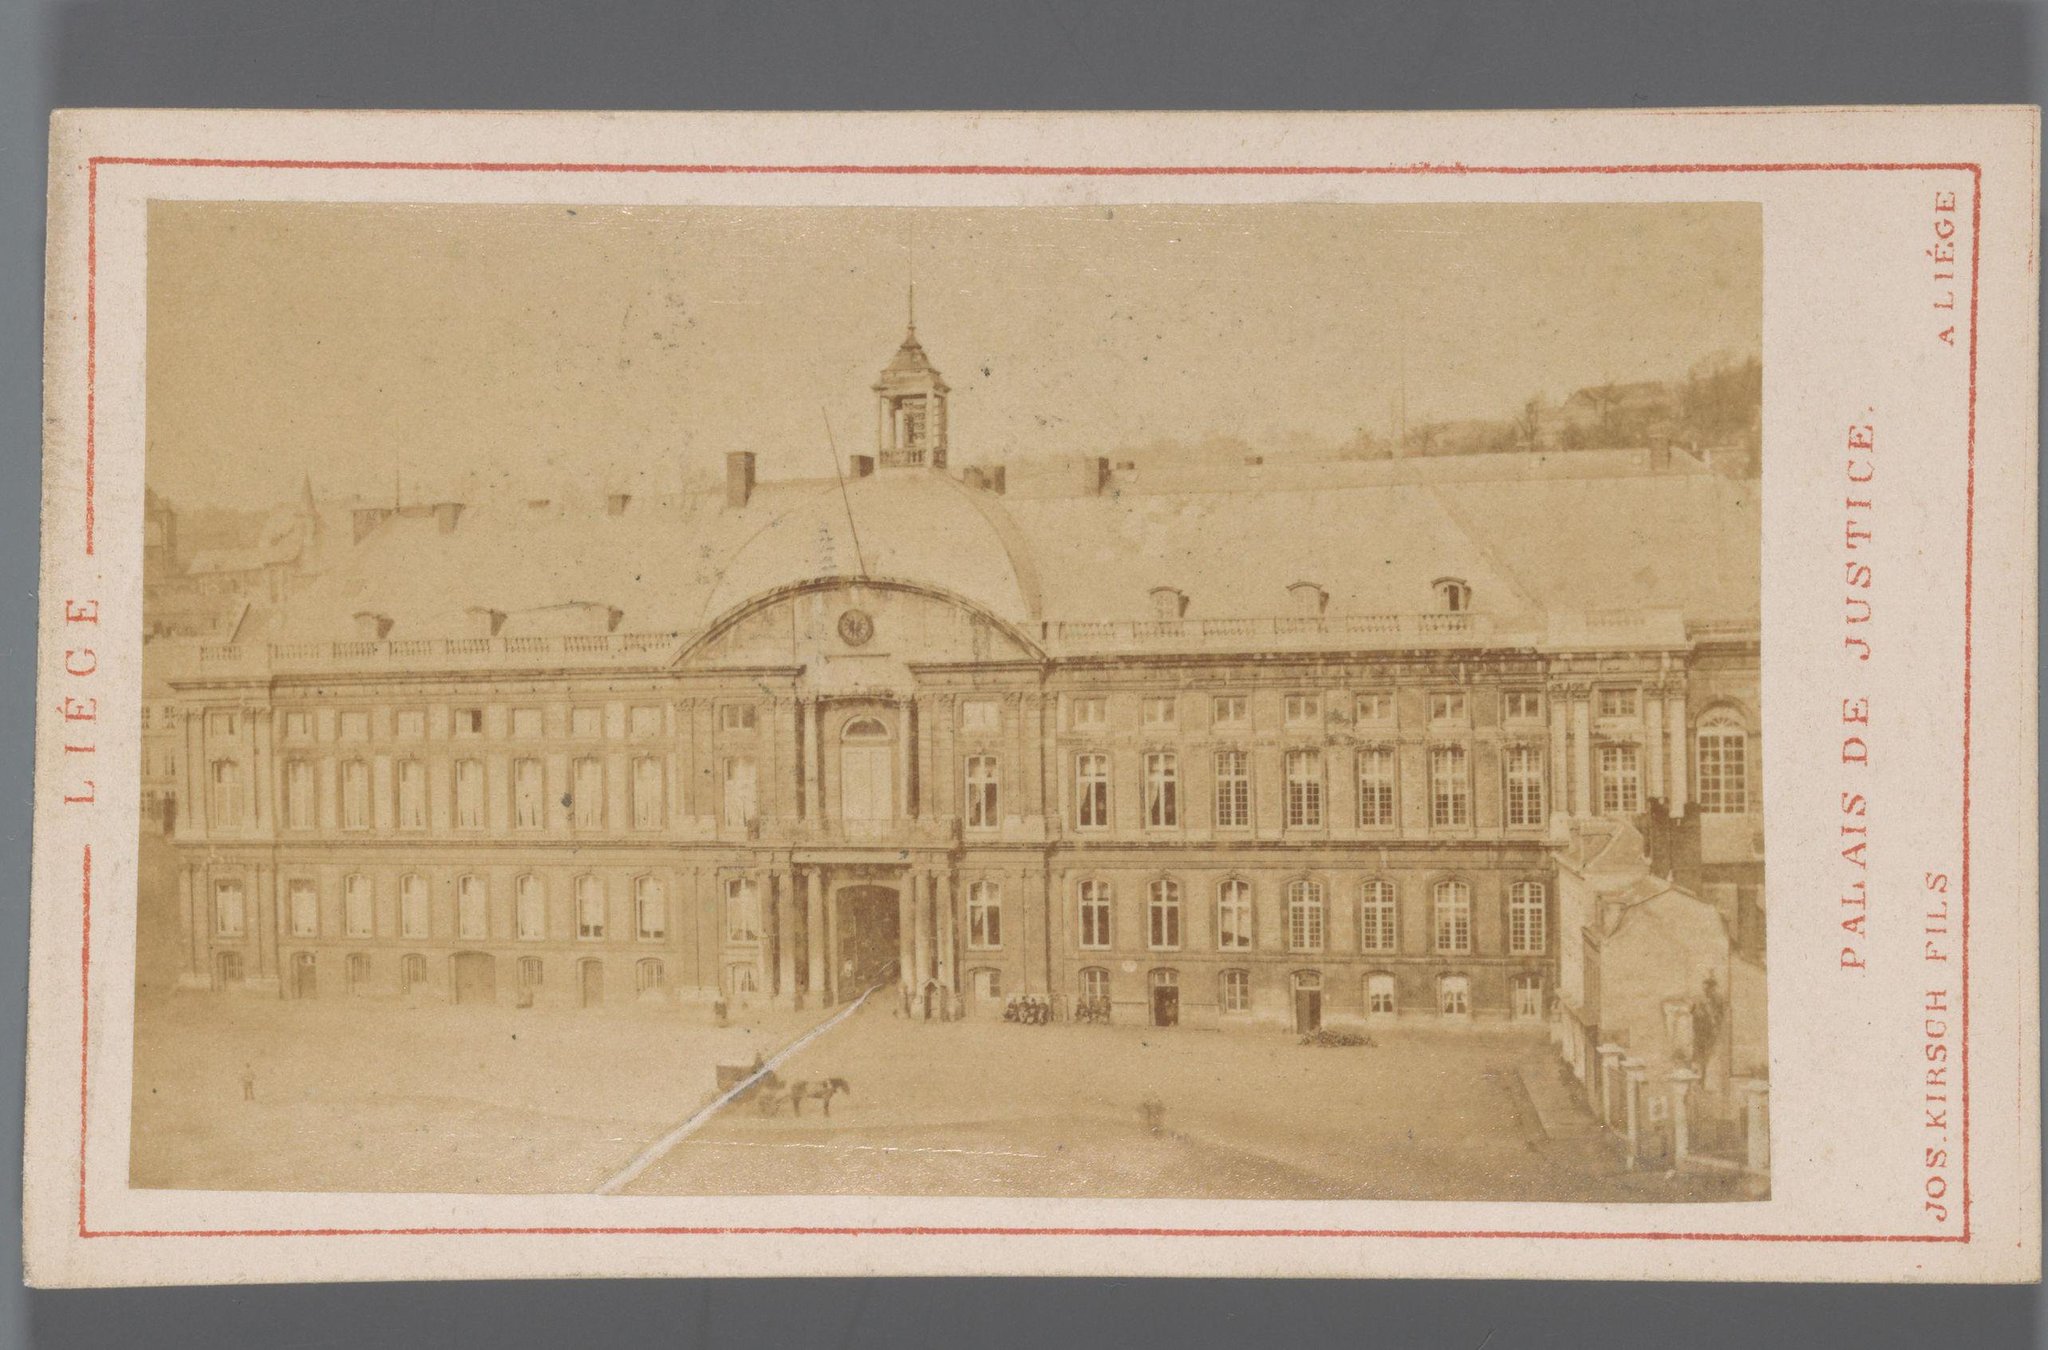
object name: carte de visite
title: Liège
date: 1862-1894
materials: cardboard, paper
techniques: albumen print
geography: liège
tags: palace